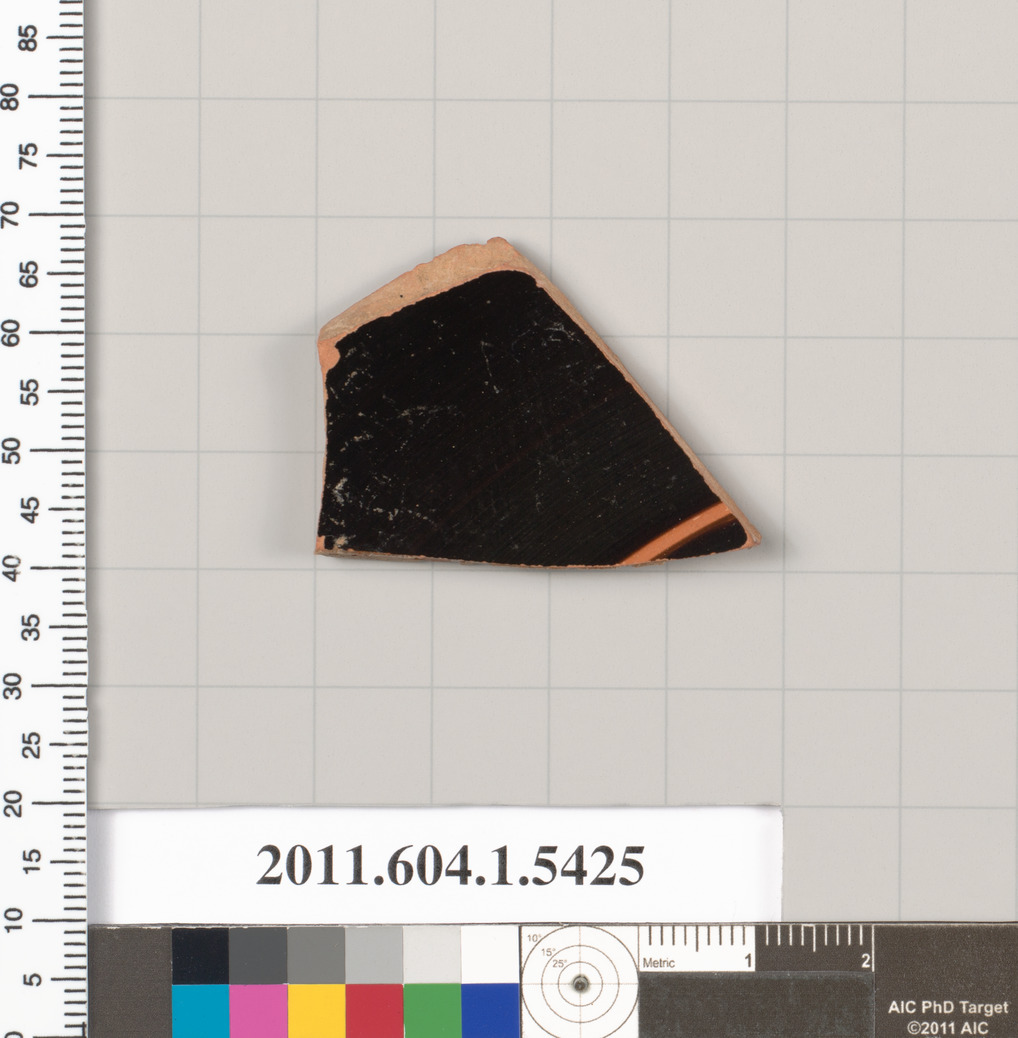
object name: kylix fragment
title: Terracotta fragment of a kylix (drinking cup)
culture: greek, attic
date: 500-490 BCE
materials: terracotta